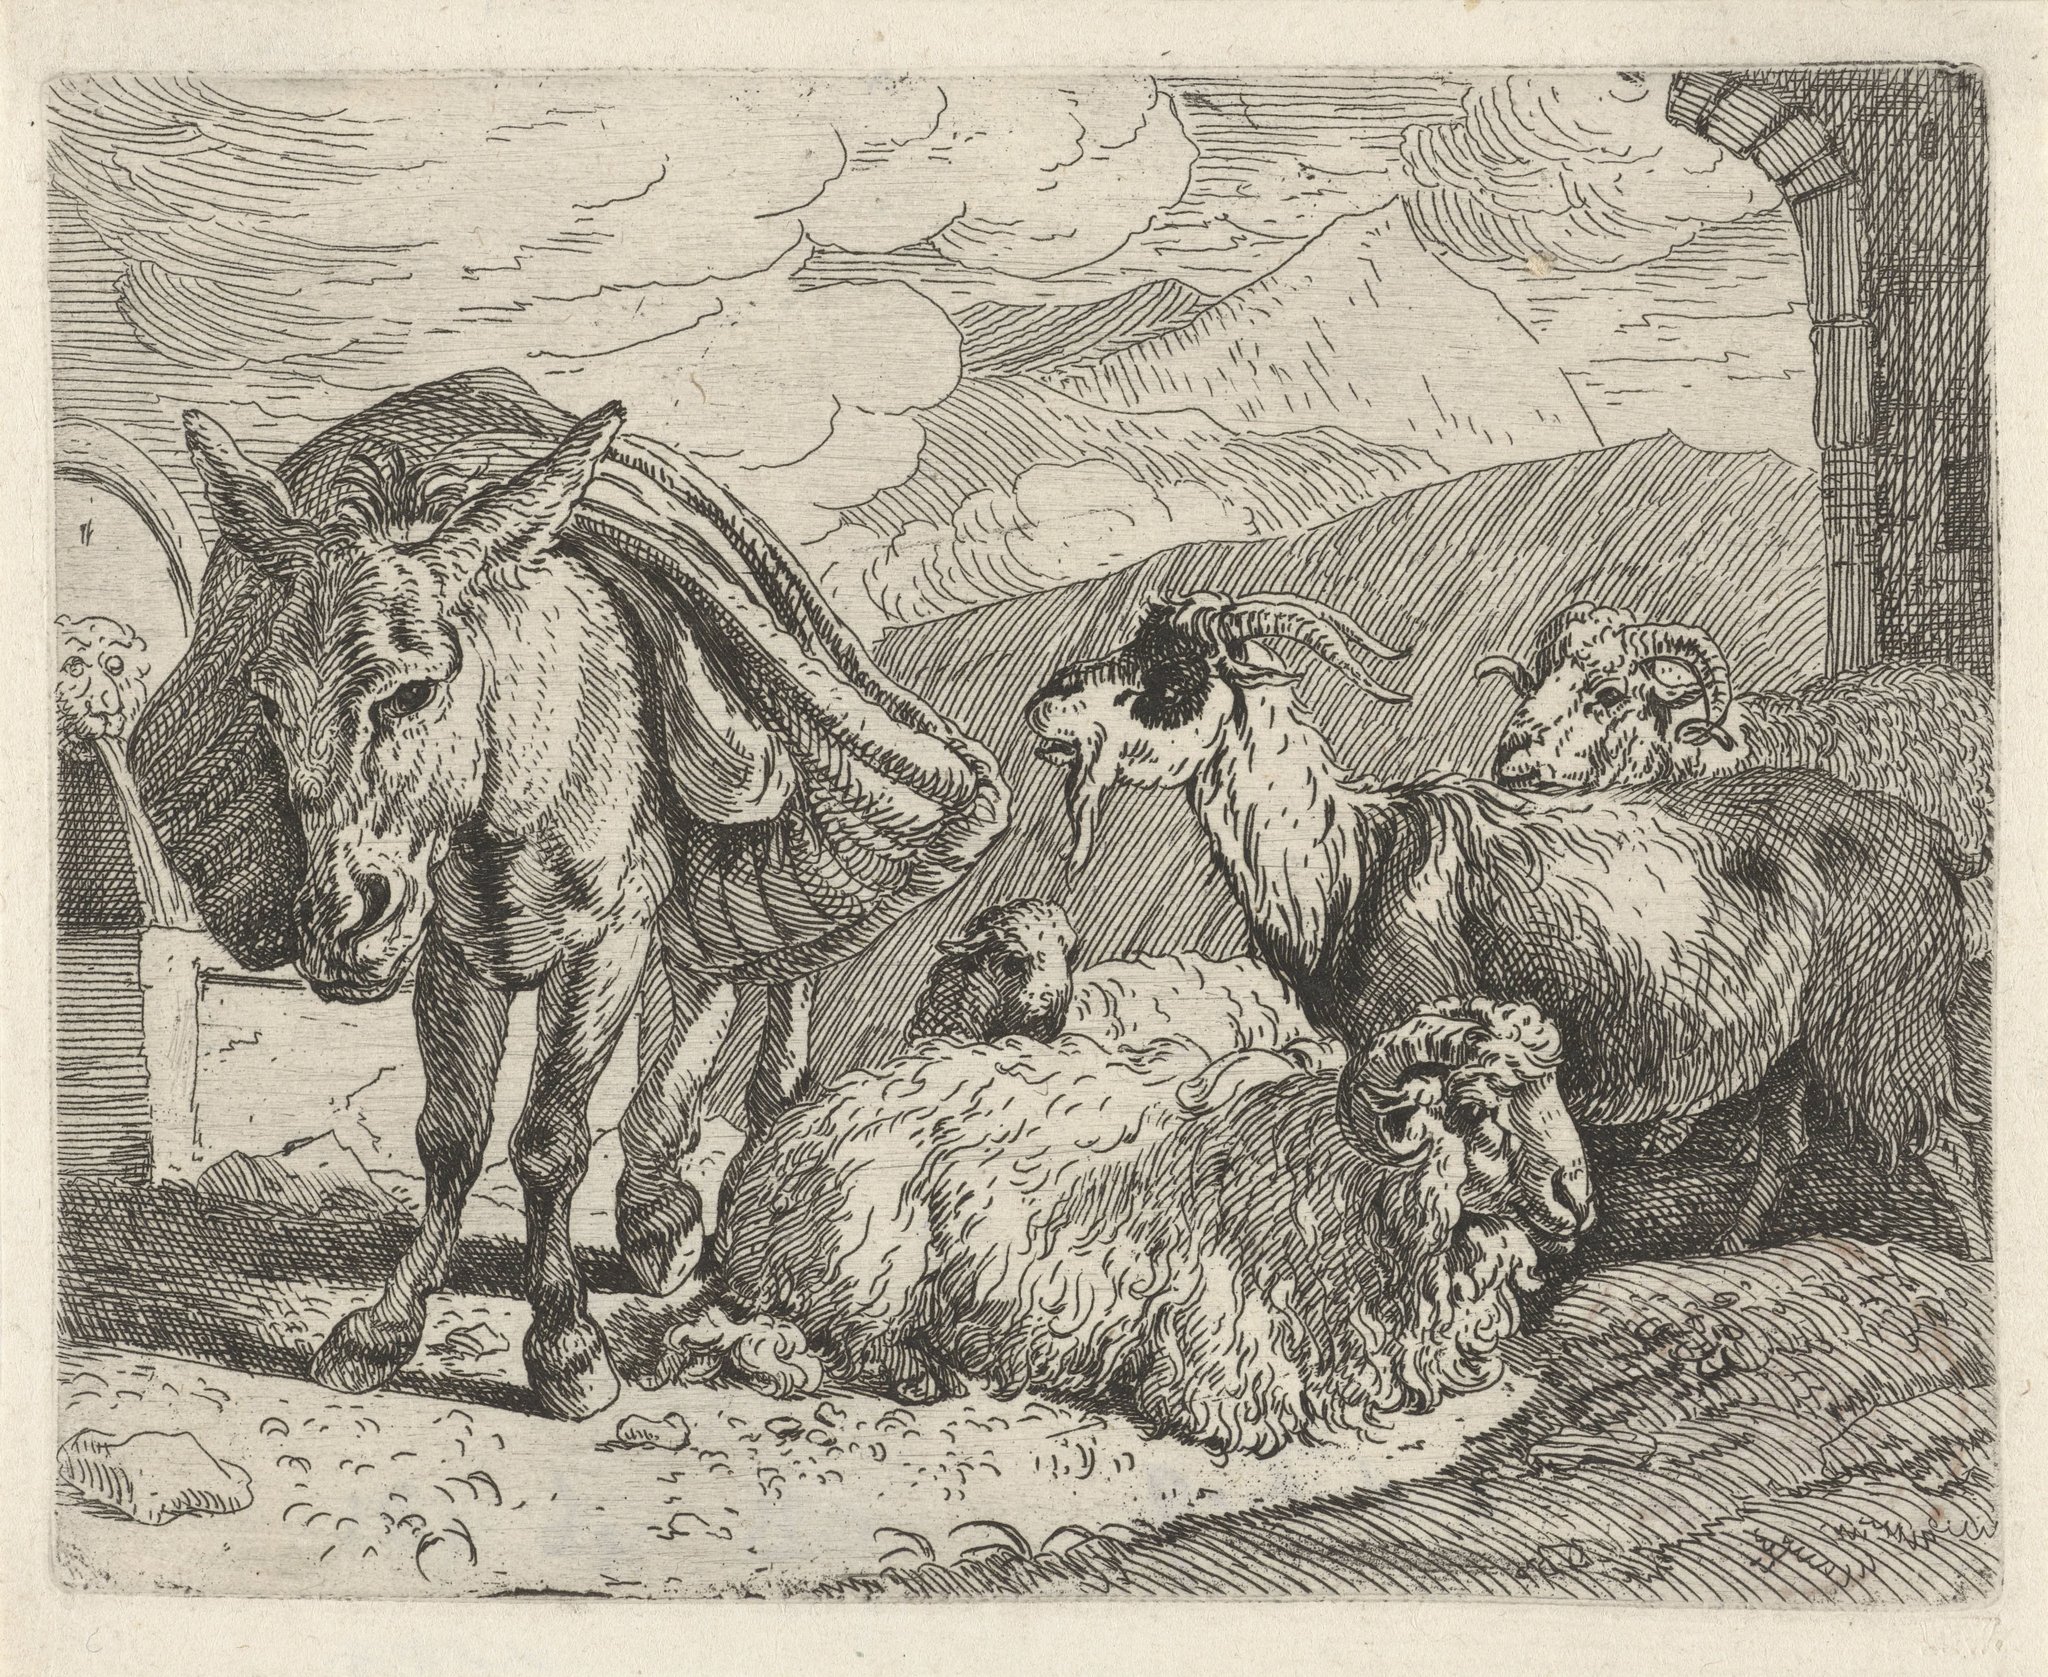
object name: print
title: Diverse dieren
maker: govert van der leeuw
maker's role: print maker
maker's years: 1645-1688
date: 1655-1688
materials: paper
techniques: etching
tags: ass, donkey, sheep, goat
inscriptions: collector's mark: Lugt 1920, collector's mark: Lugt 240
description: Een ezel, drie schapen en een geit in een landschap. De prent maakt deel uit van een negendelige serie prenten met voorstellingen van diverse dieren.